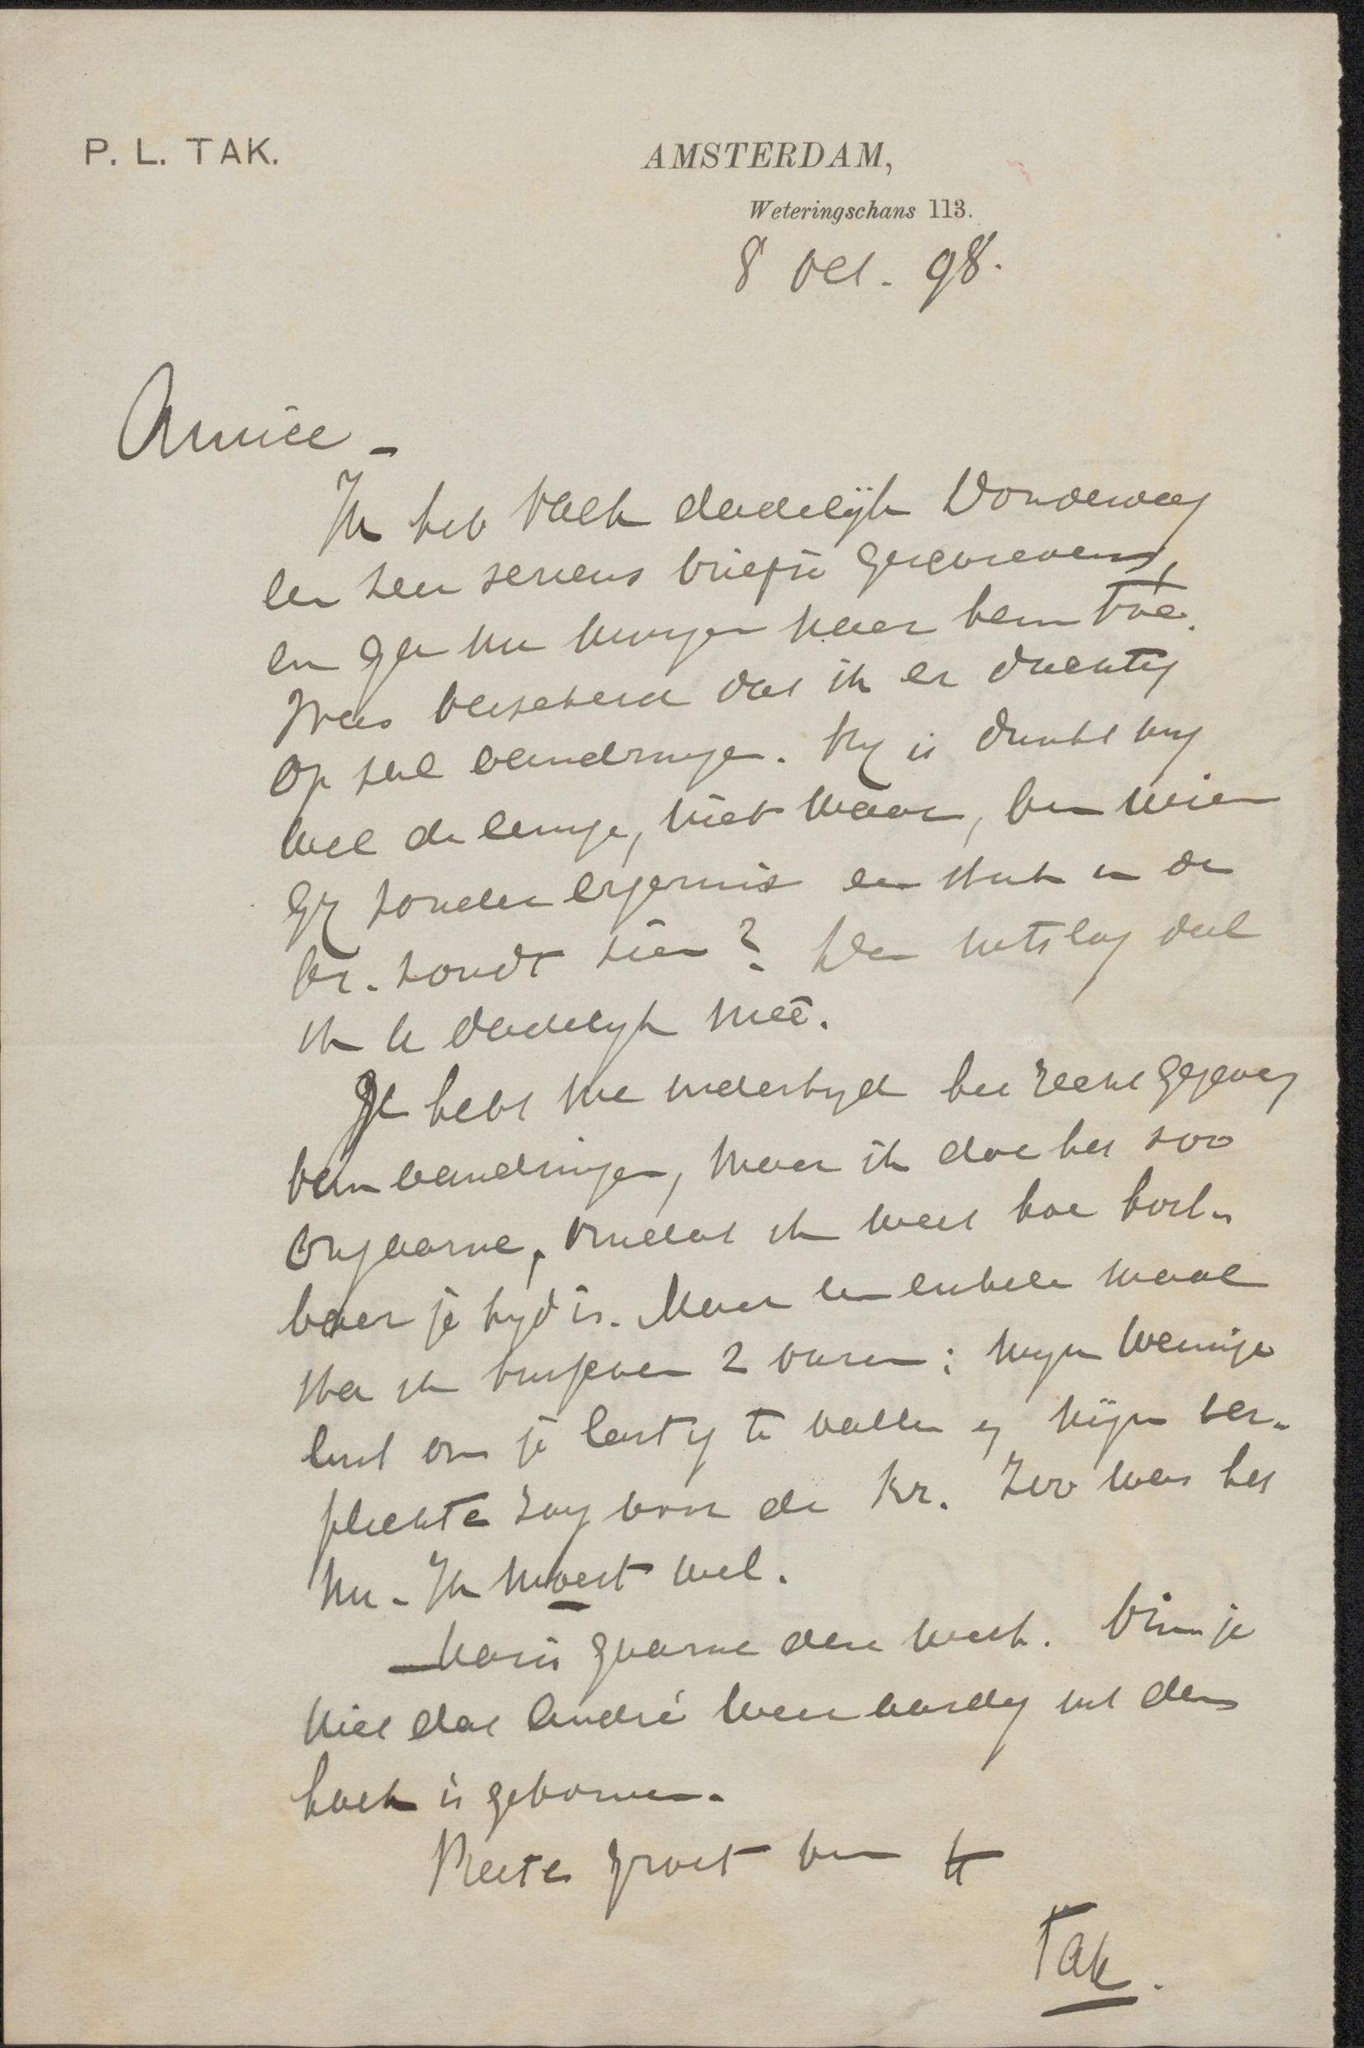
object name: letter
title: Brief aan Jan Veth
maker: pieter lodewijk tak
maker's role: politician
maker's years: 1848-1907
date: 1898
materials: ink, paper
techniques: pen, printing, writing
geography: amsterdam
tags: painter, print maker, draughtsman, jan veth, maurits van der valk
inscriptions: collector's mark: ‘RPK’, watermark